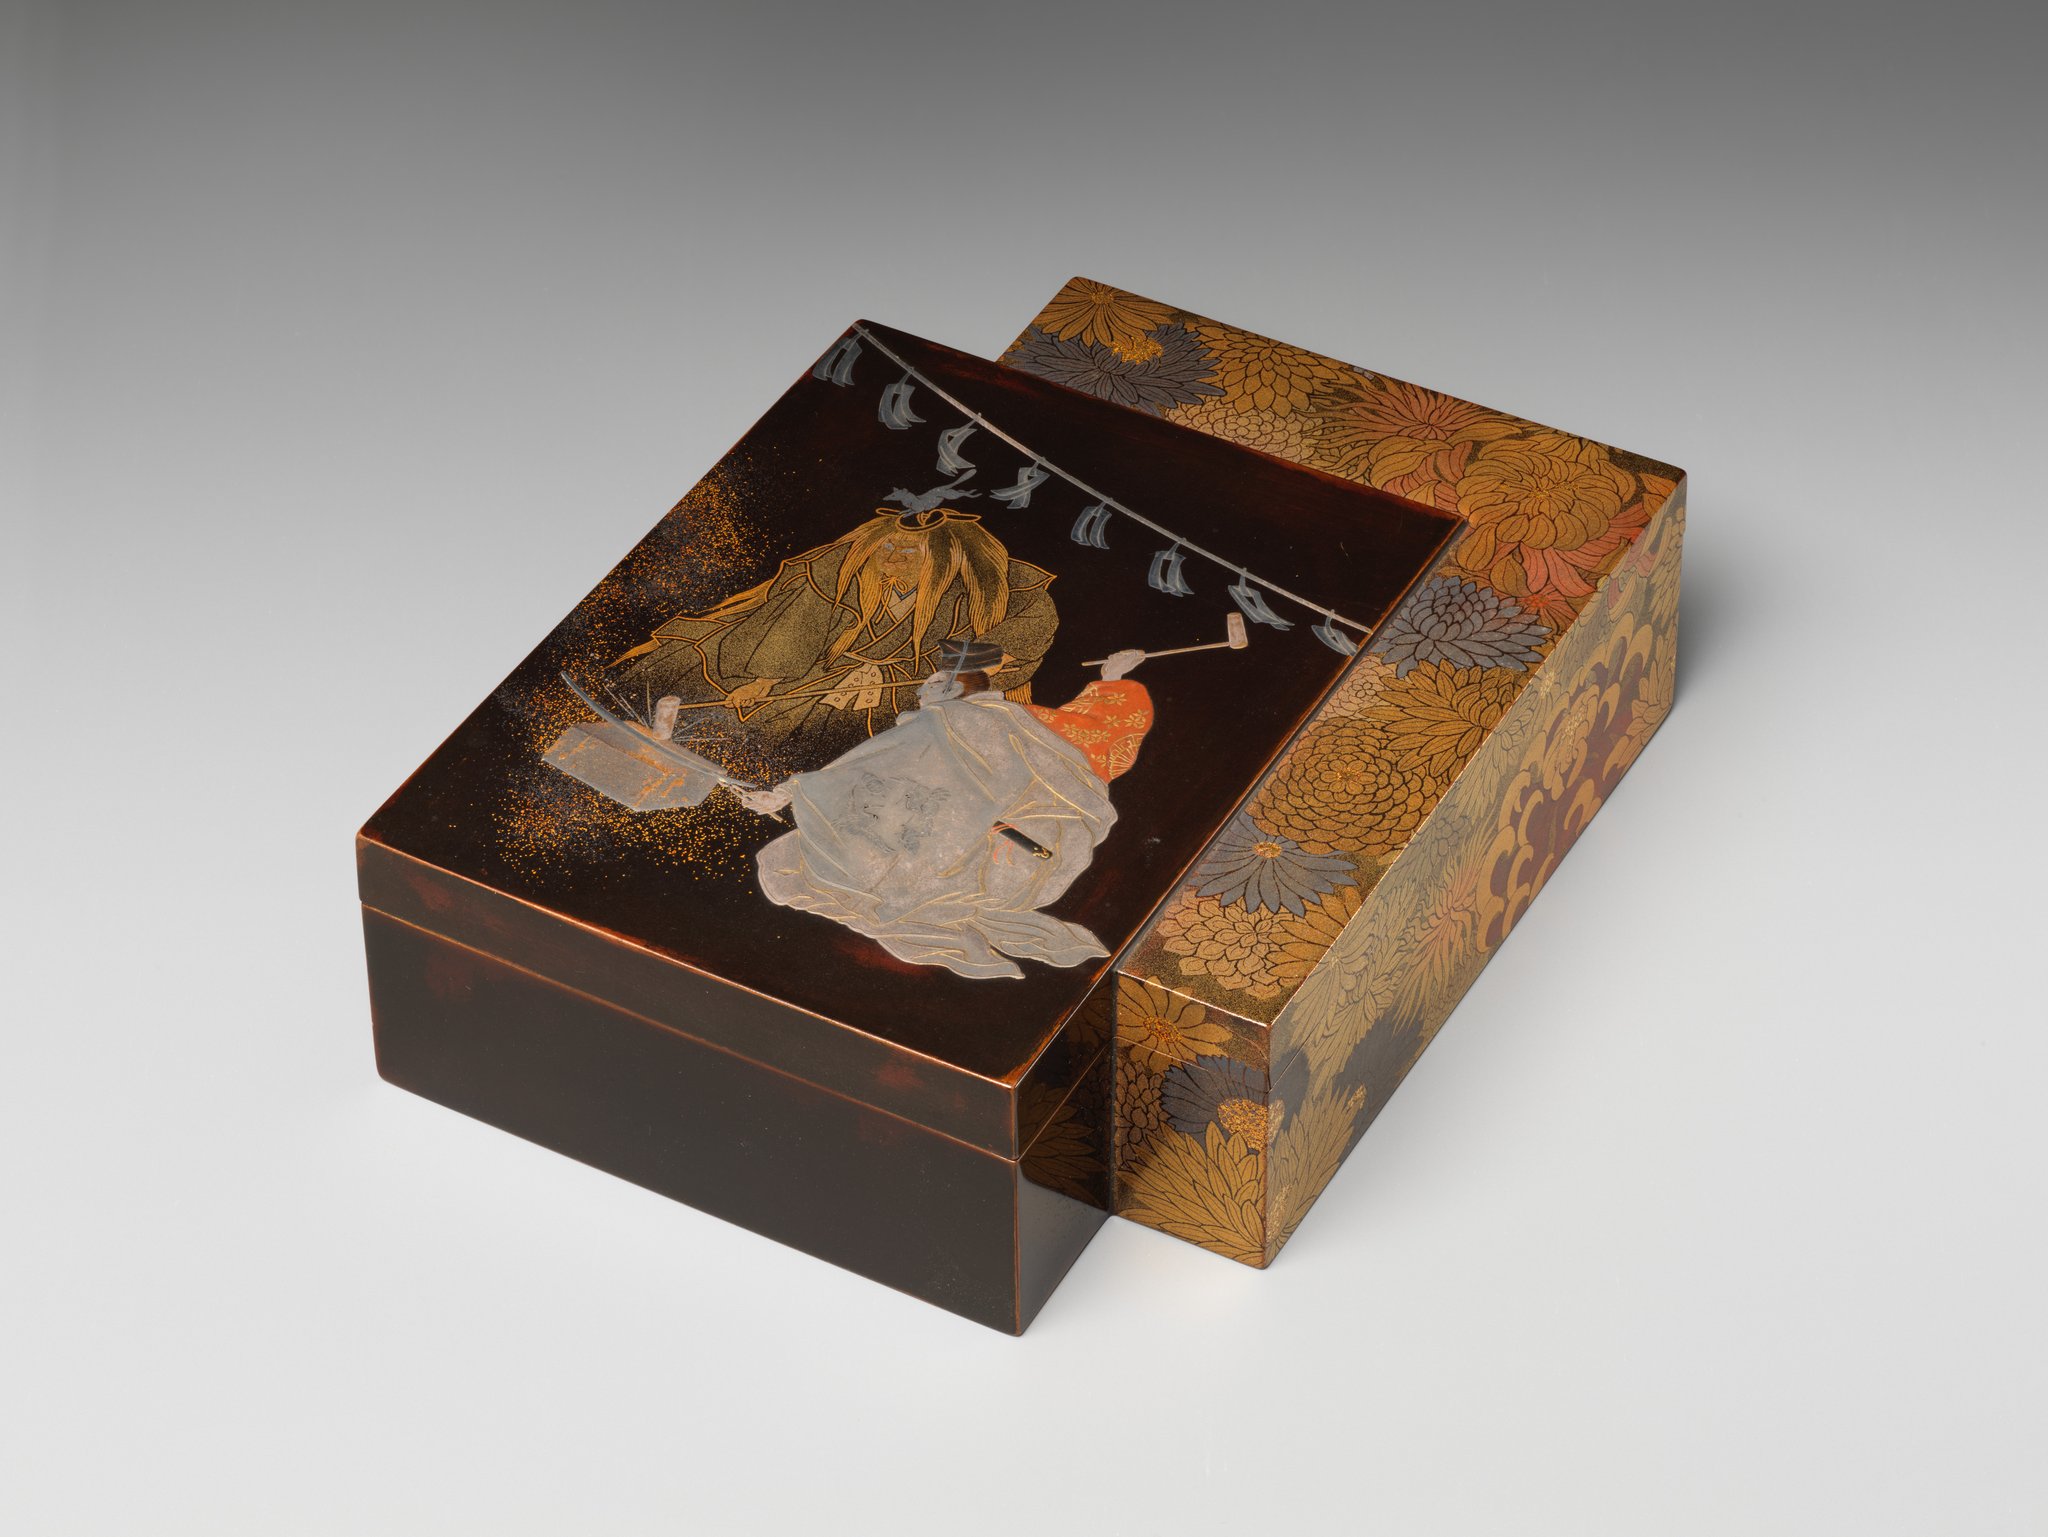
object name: box with tray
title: Incense Box with Scene from Noh Play Kokaji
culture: japanese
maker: koma school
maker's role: artist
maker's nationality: japanese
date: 1851-1900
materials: gold, lacquer, silver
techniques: hiramakie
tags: men